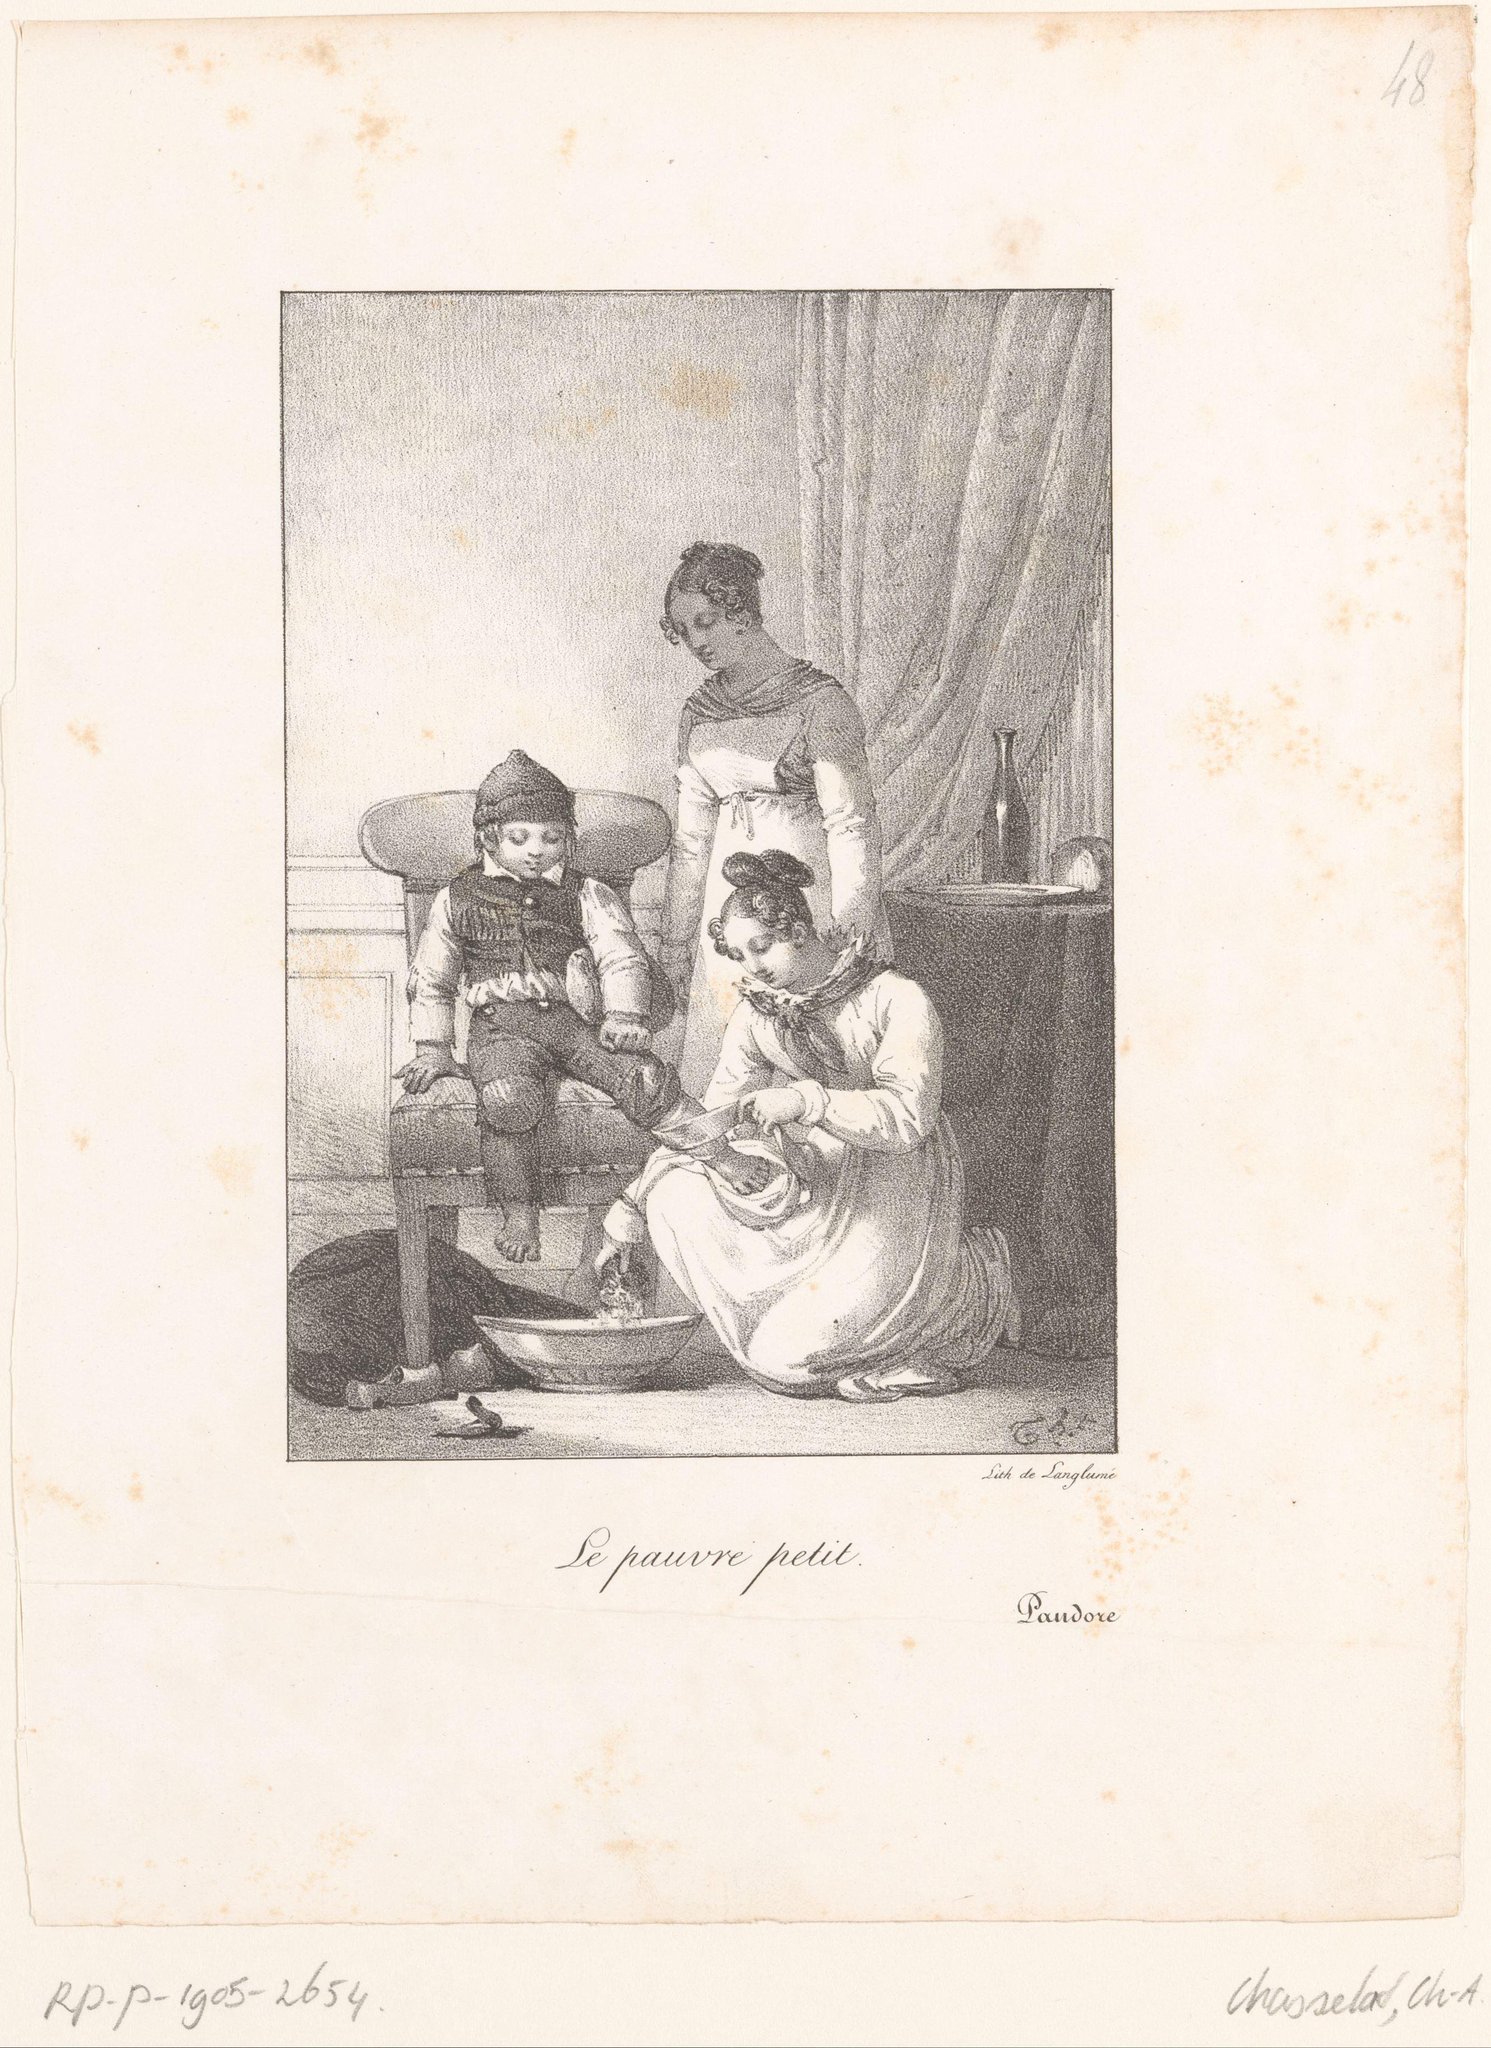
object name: print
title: Vrouw wast en verbindt de wond van een jongen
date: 1823-1830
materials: paper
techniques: lithograph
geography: paris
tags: applying dressing or bandage, hygienic care of children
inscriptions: number: ‘48’, collector's mark: Lugt 2228a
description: Prent in: 'La Pandore: journal des spectacles, des lettres, des arts, des moeurs et des modes', een dagblad dat werd gepubliceerd in Parijs tussen 1823 en 1830.